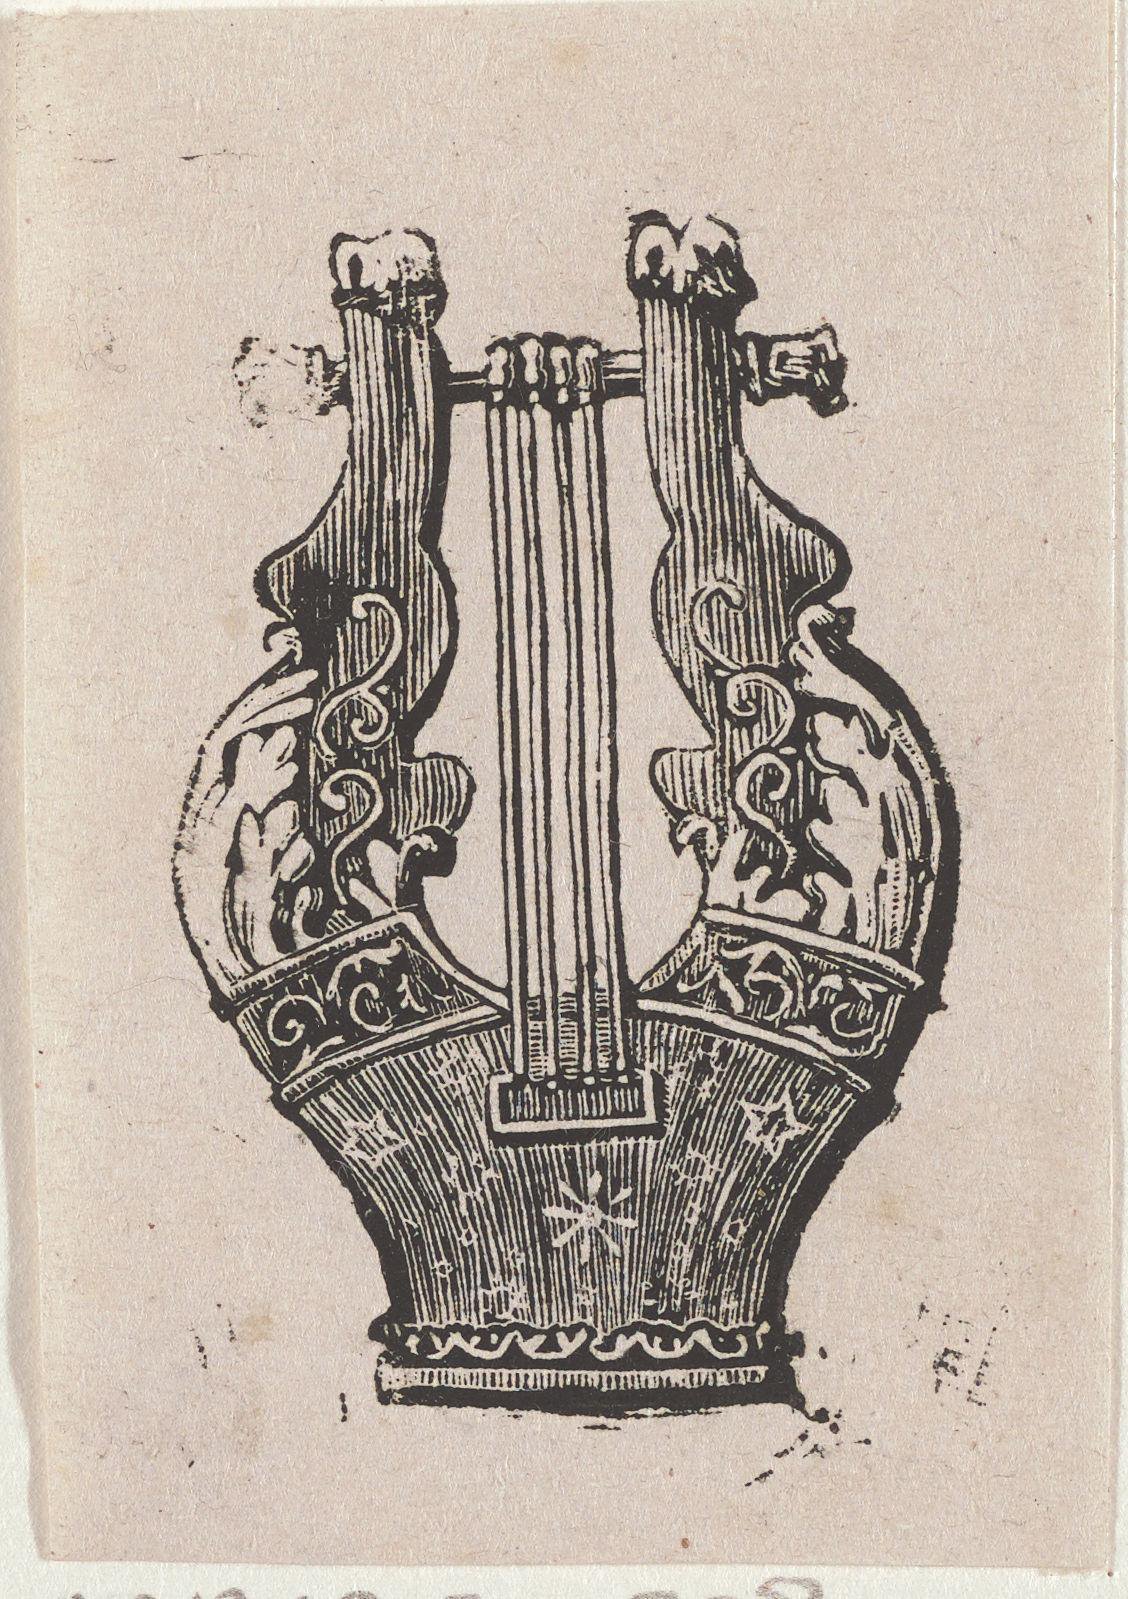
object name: print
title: Geornamenteerde lier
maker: isaac weissenbruch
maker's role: print maker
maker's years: 1826-1912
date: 1836-1912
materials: paper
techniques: engraving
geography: netherlands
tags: lyre, cithara, psaltery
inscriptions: collector's mark: Lugt 2228